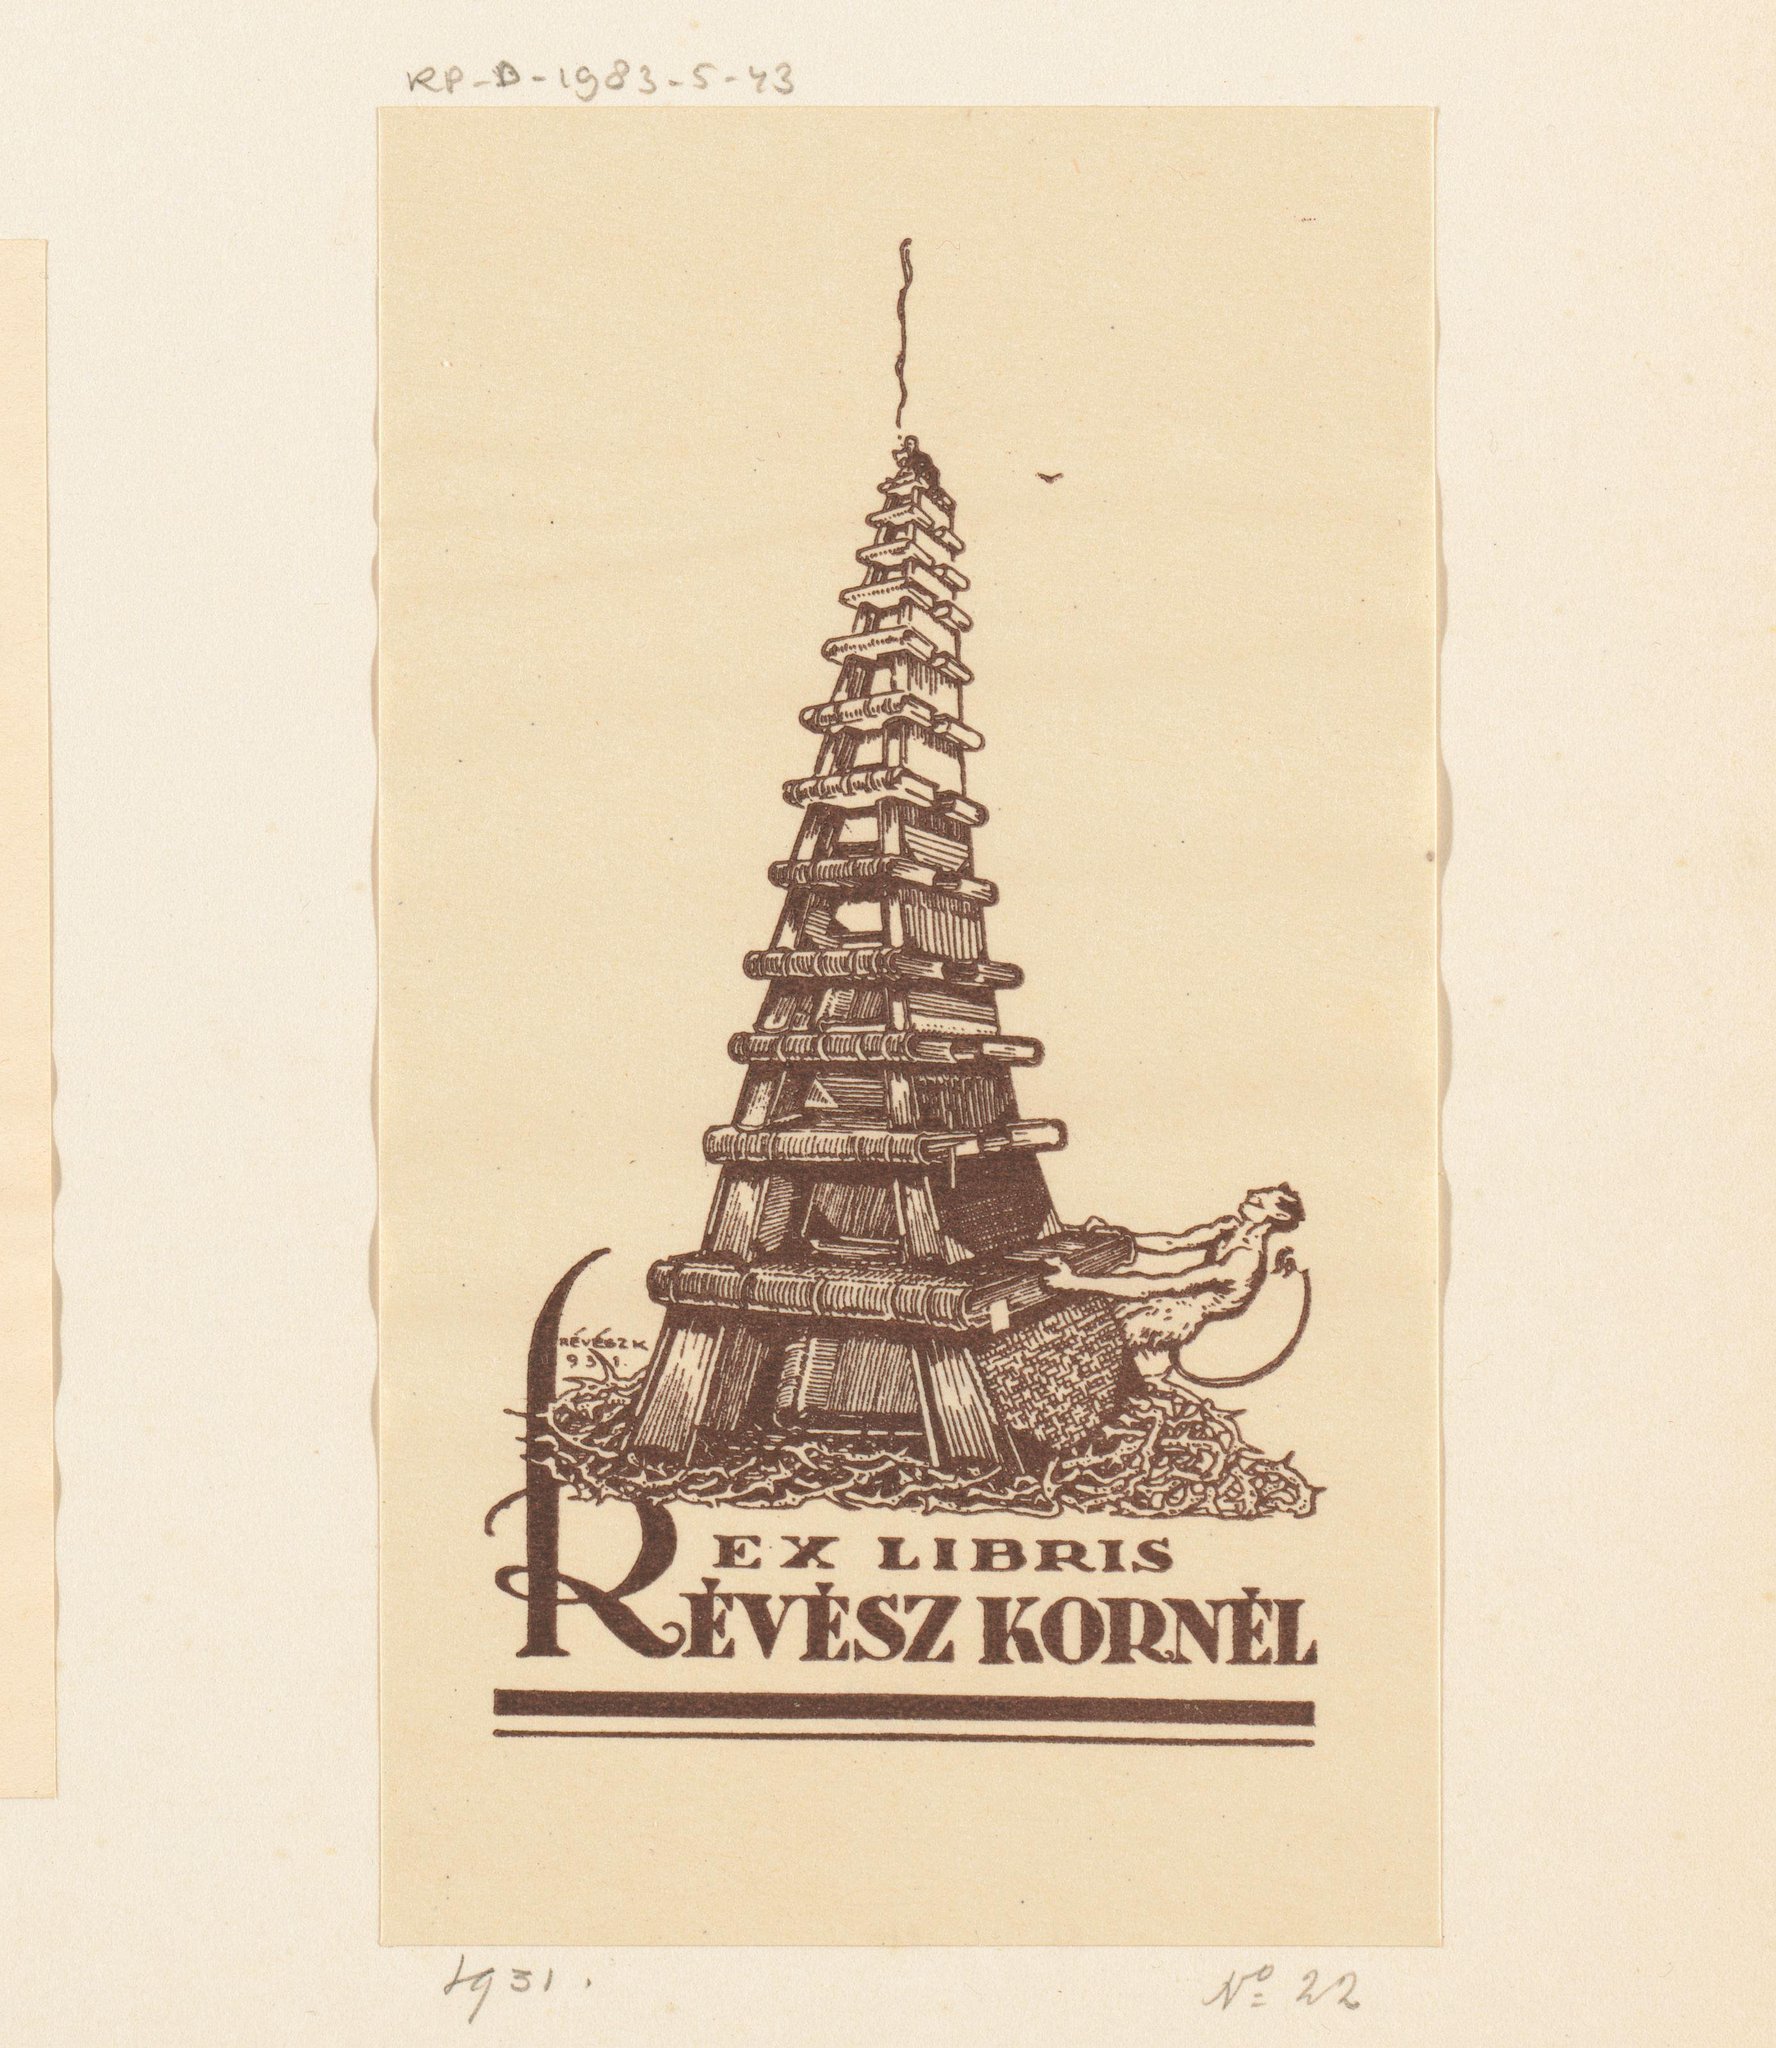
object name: bookplate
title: Ex libris van Kornél Révész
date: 1931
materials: paper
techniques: printing block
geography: budapest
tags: print maker, kornél révész, devil(s) and demons, book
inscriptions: date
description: Ex libris maakt deel uit van omslag met 64 ex libris op 34 losse opzetvellen, een catalogus en een tekstblad.